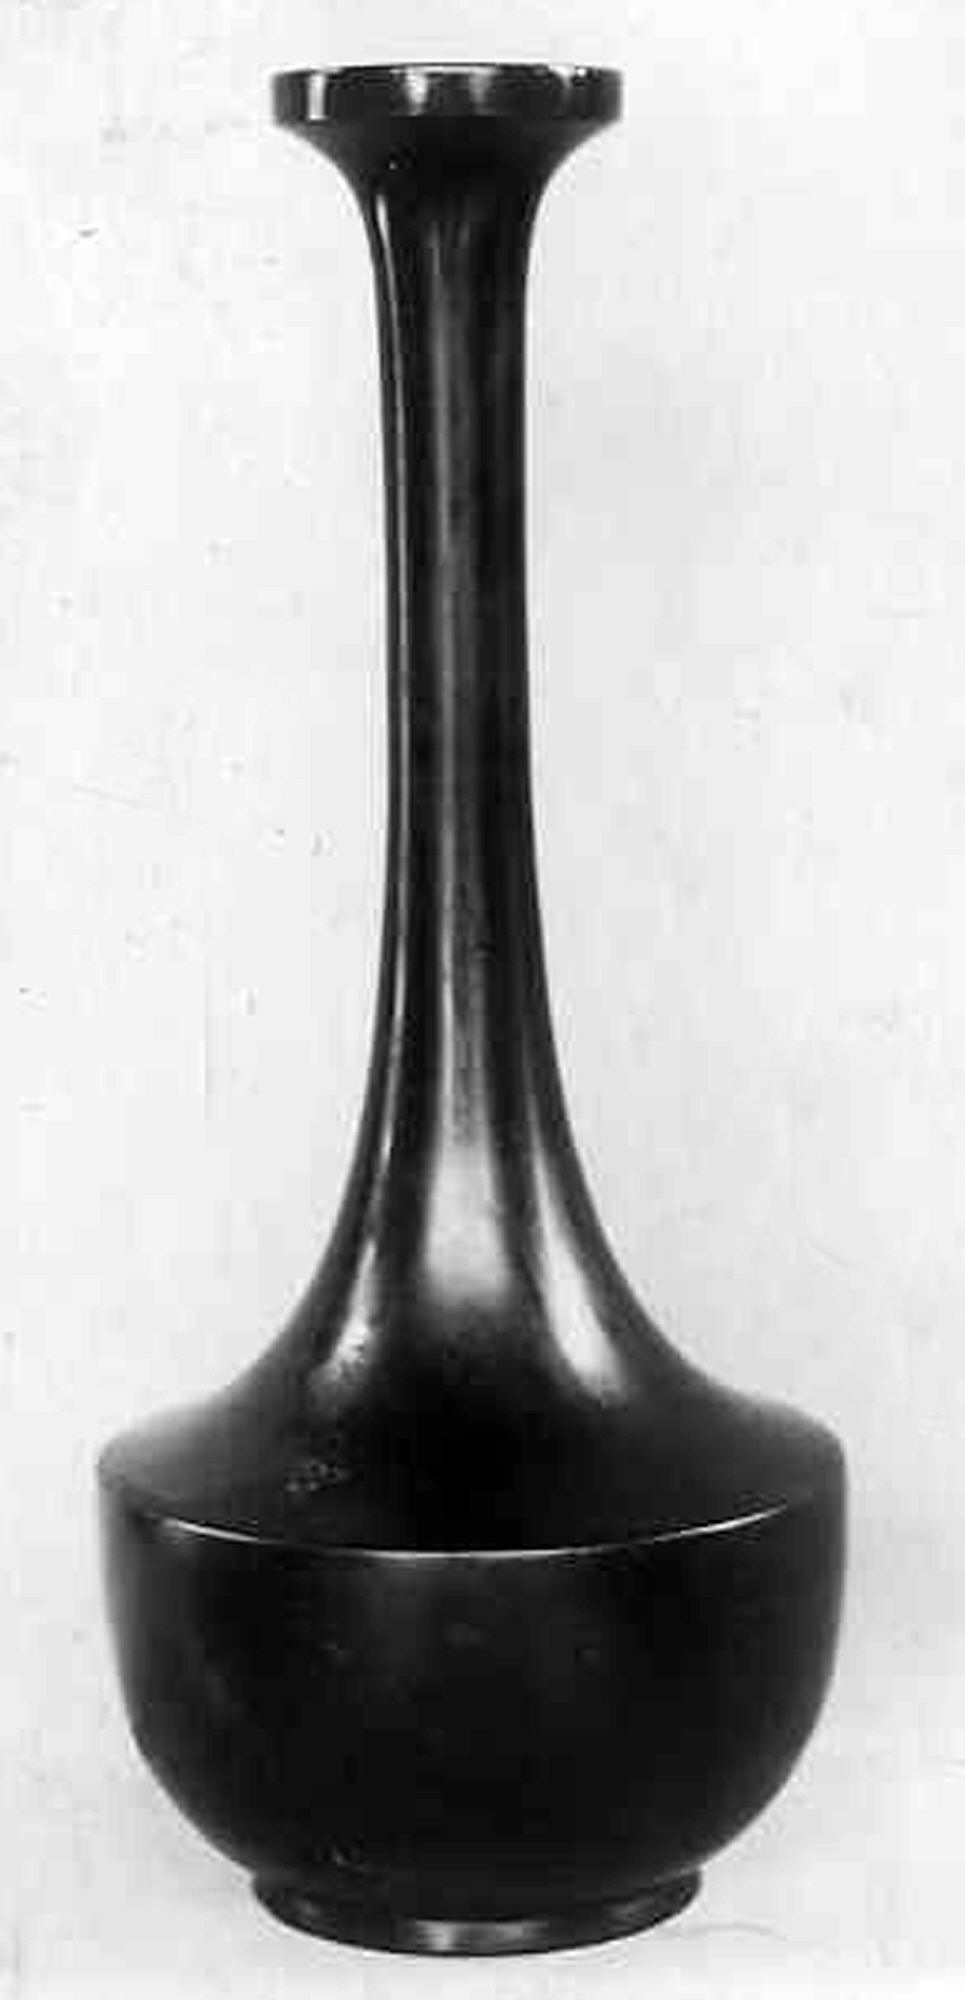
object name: vase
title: Flower Vase in "Crane's Neck" shape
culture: japanese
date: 1734-1900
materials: bronze